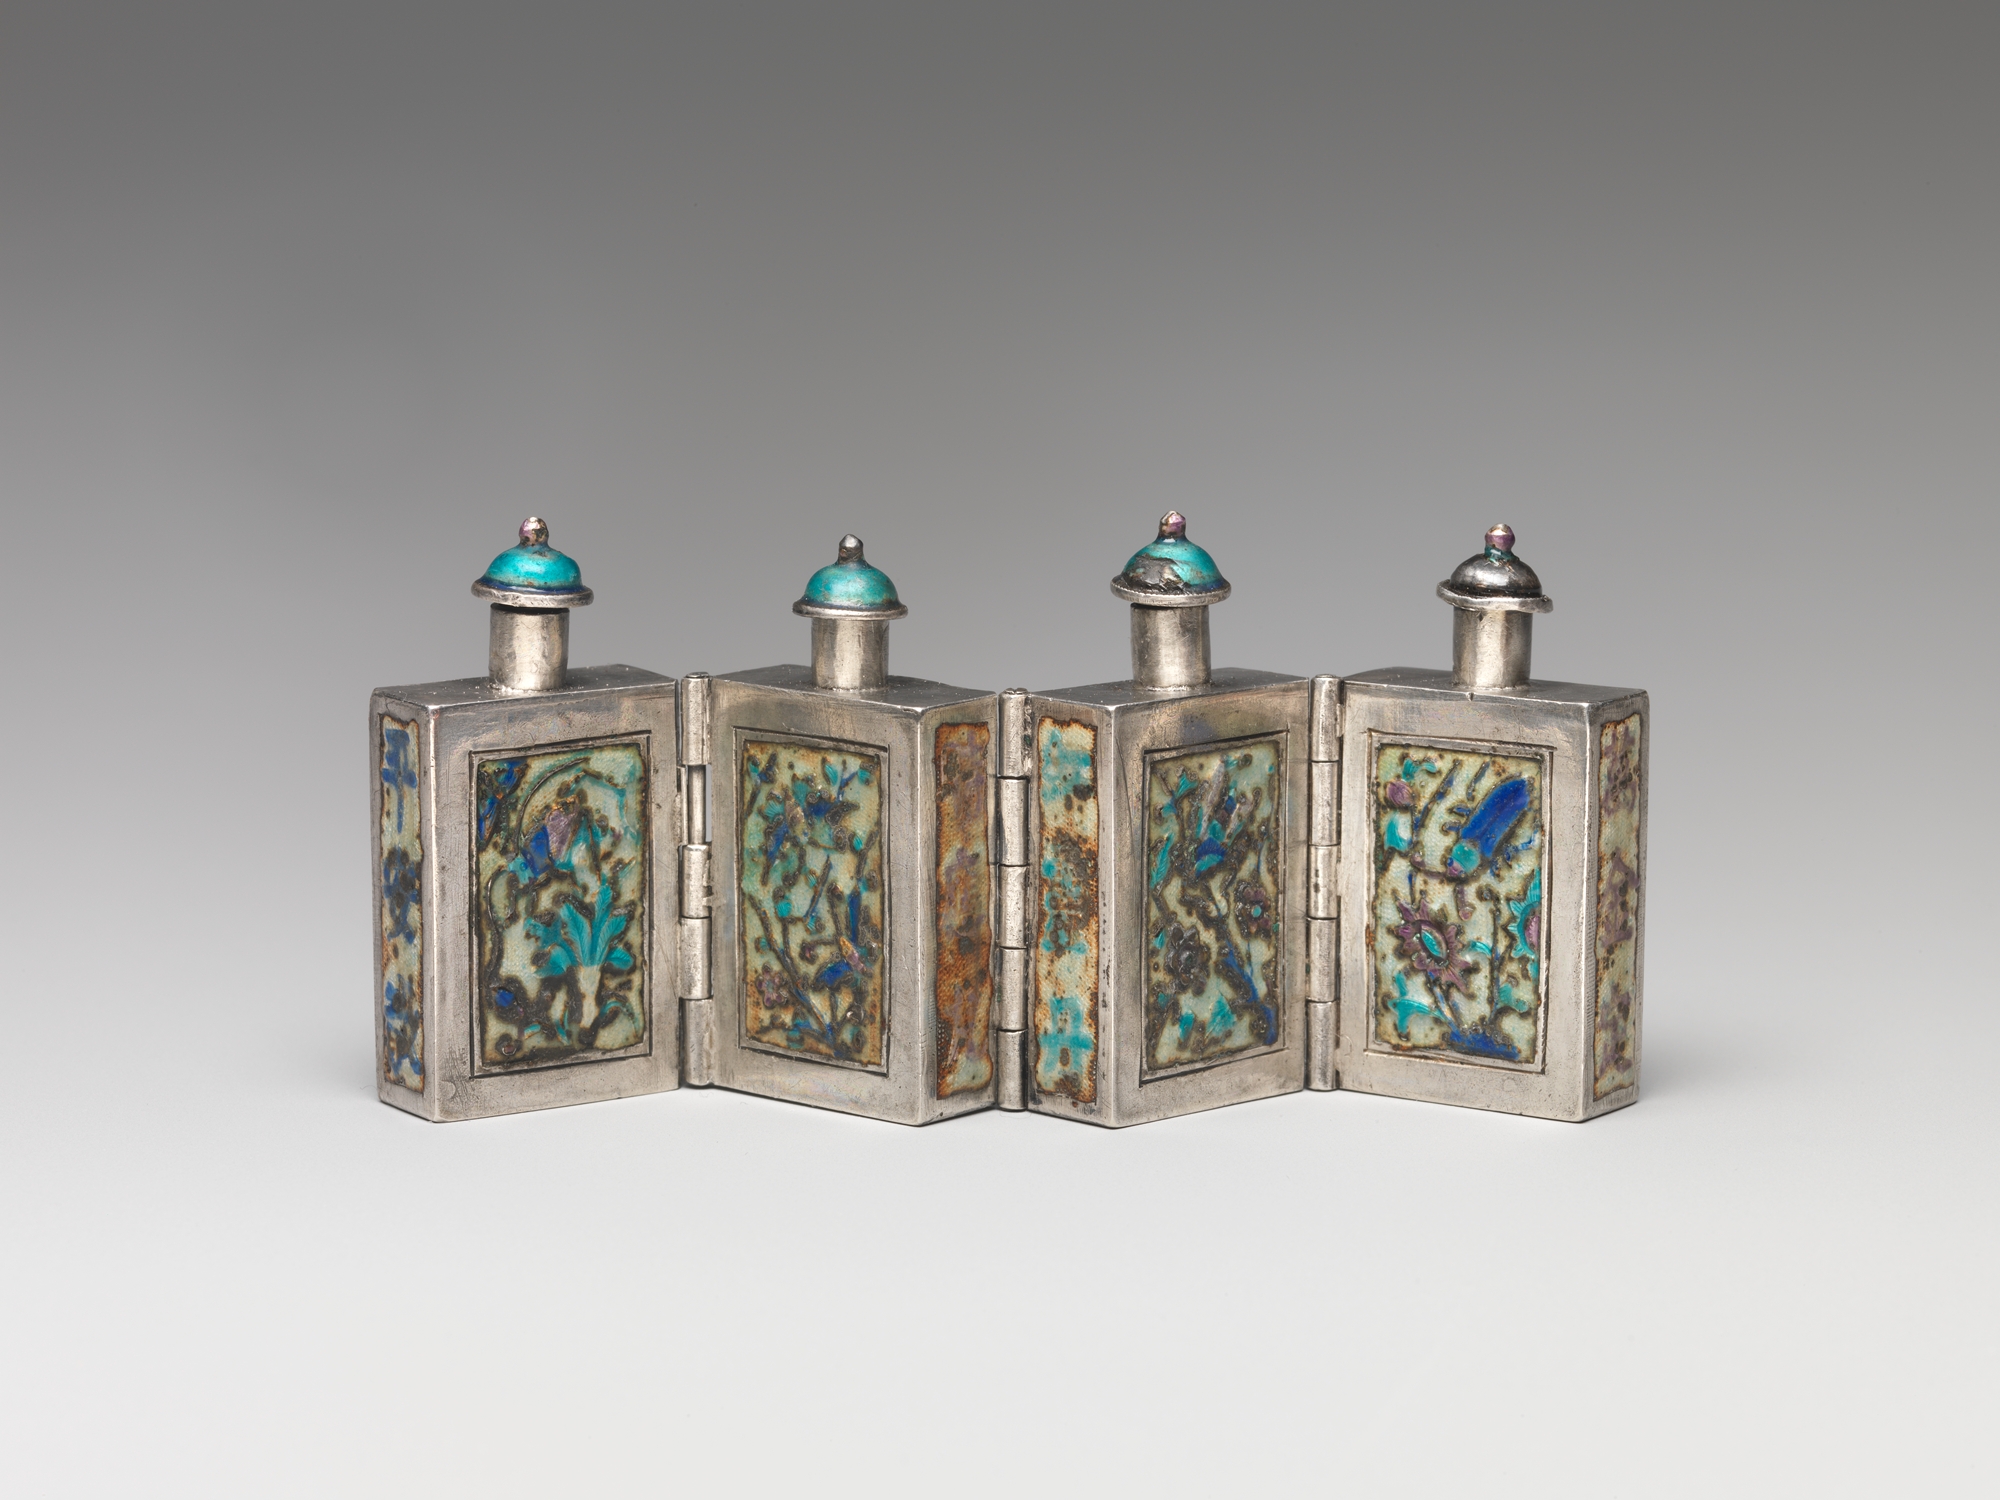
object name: snuff bottle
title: Hinged Snuff Bottles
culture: chinese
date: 1801-1900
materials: enamel, panel, silver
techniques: painting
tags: insects,flowers